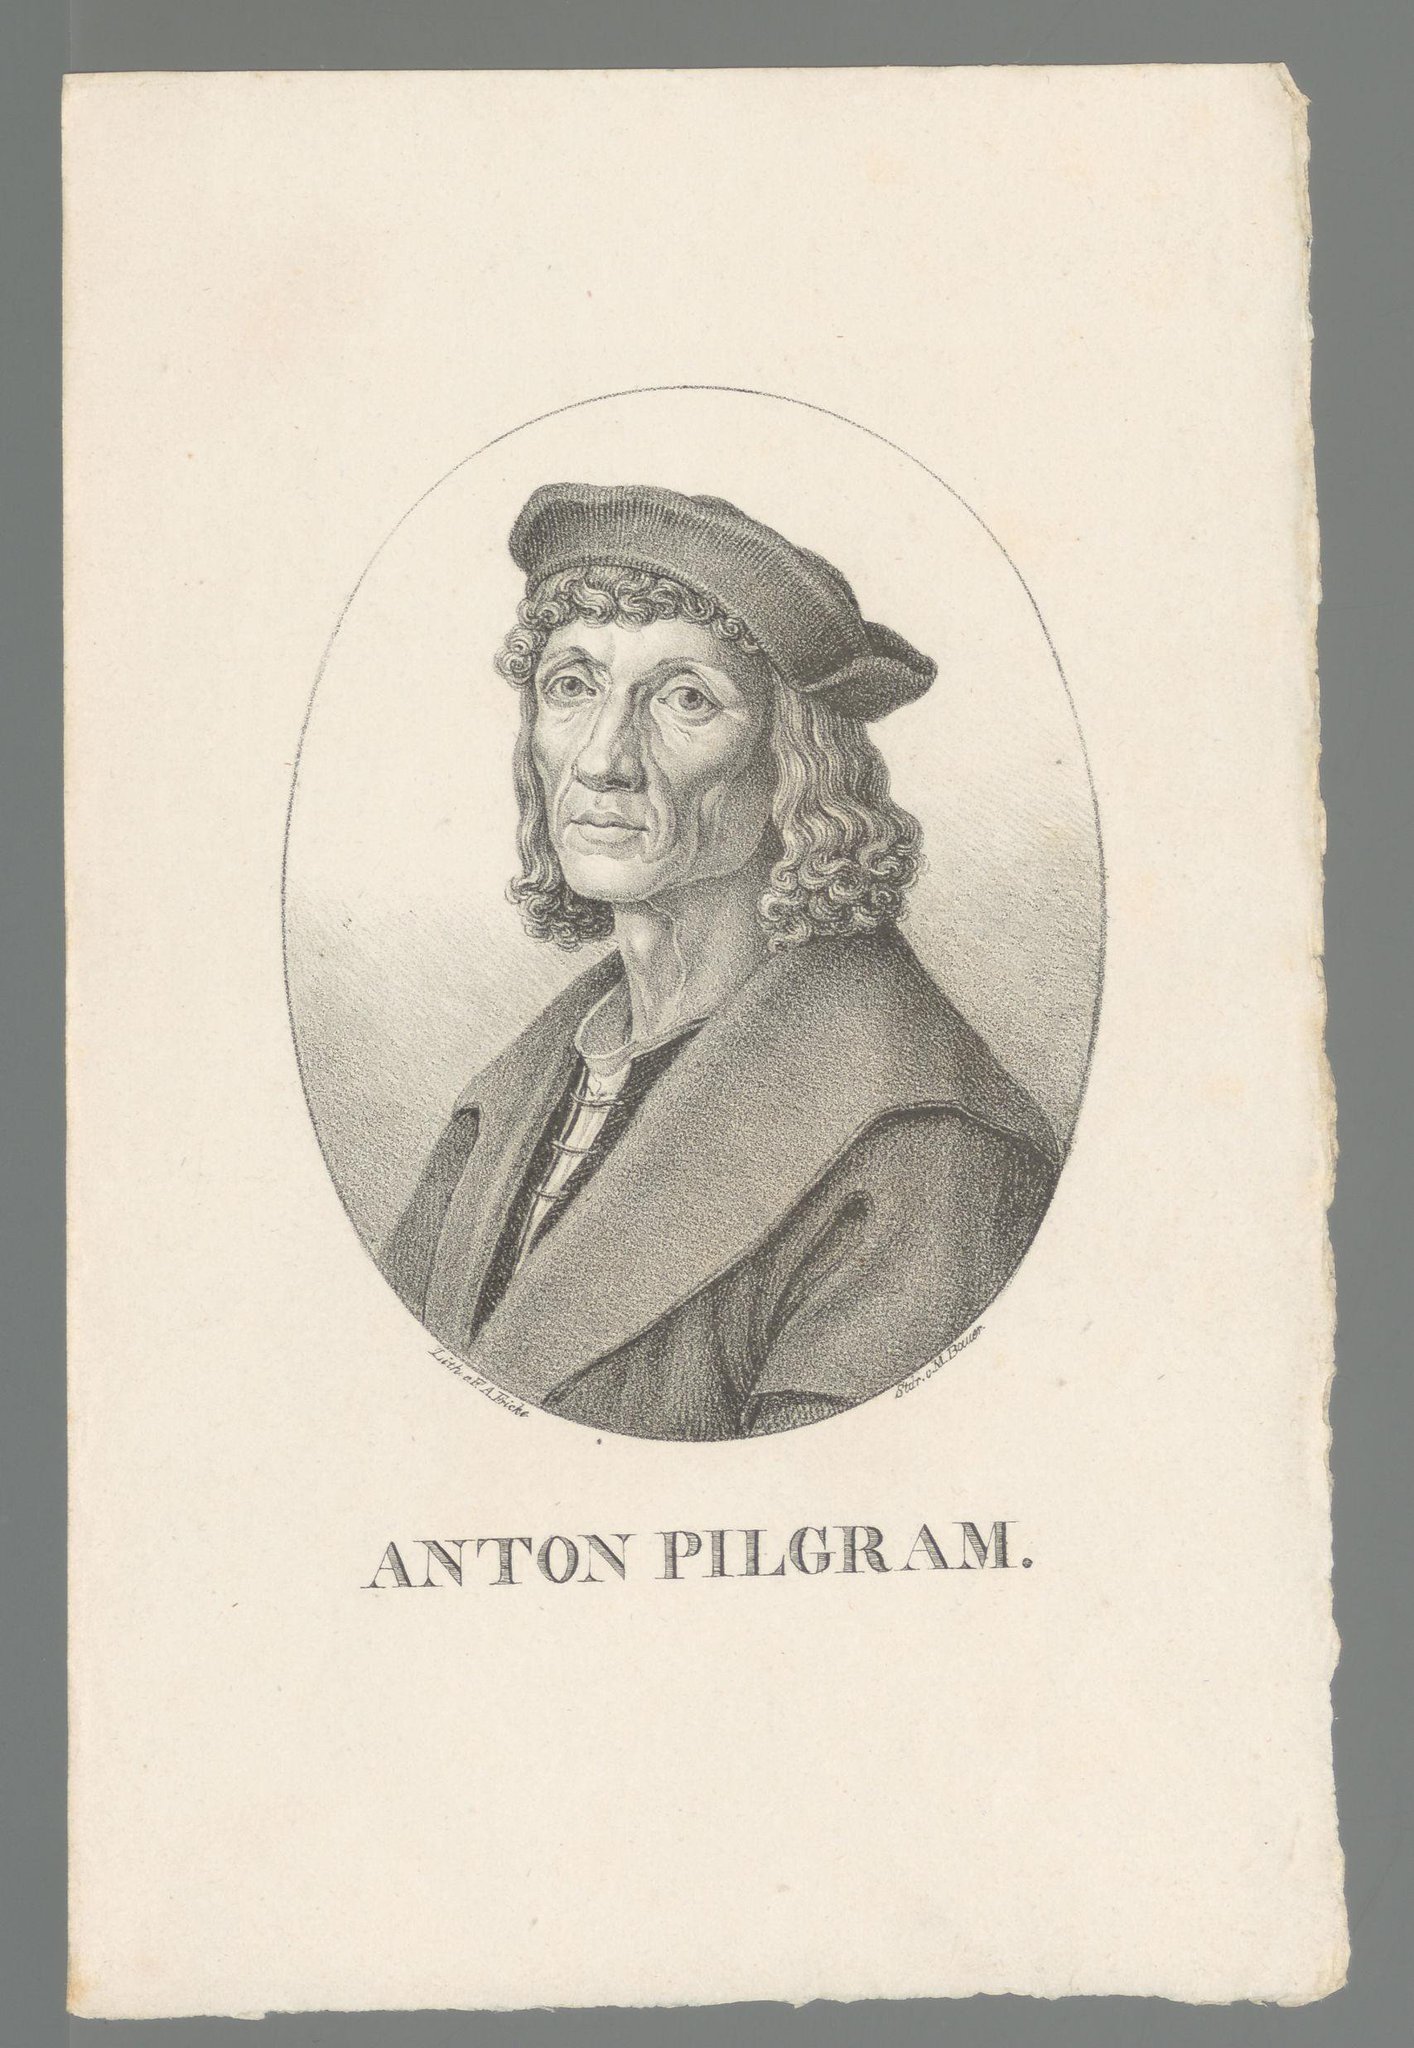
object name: print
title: Portret van Anton Pilgram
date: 1794-1858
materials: paper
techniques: lithograph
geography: leipzig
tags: adult man, historical persons, portrait, self-portrait of architect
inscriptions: collector's mark: Lugt 2228